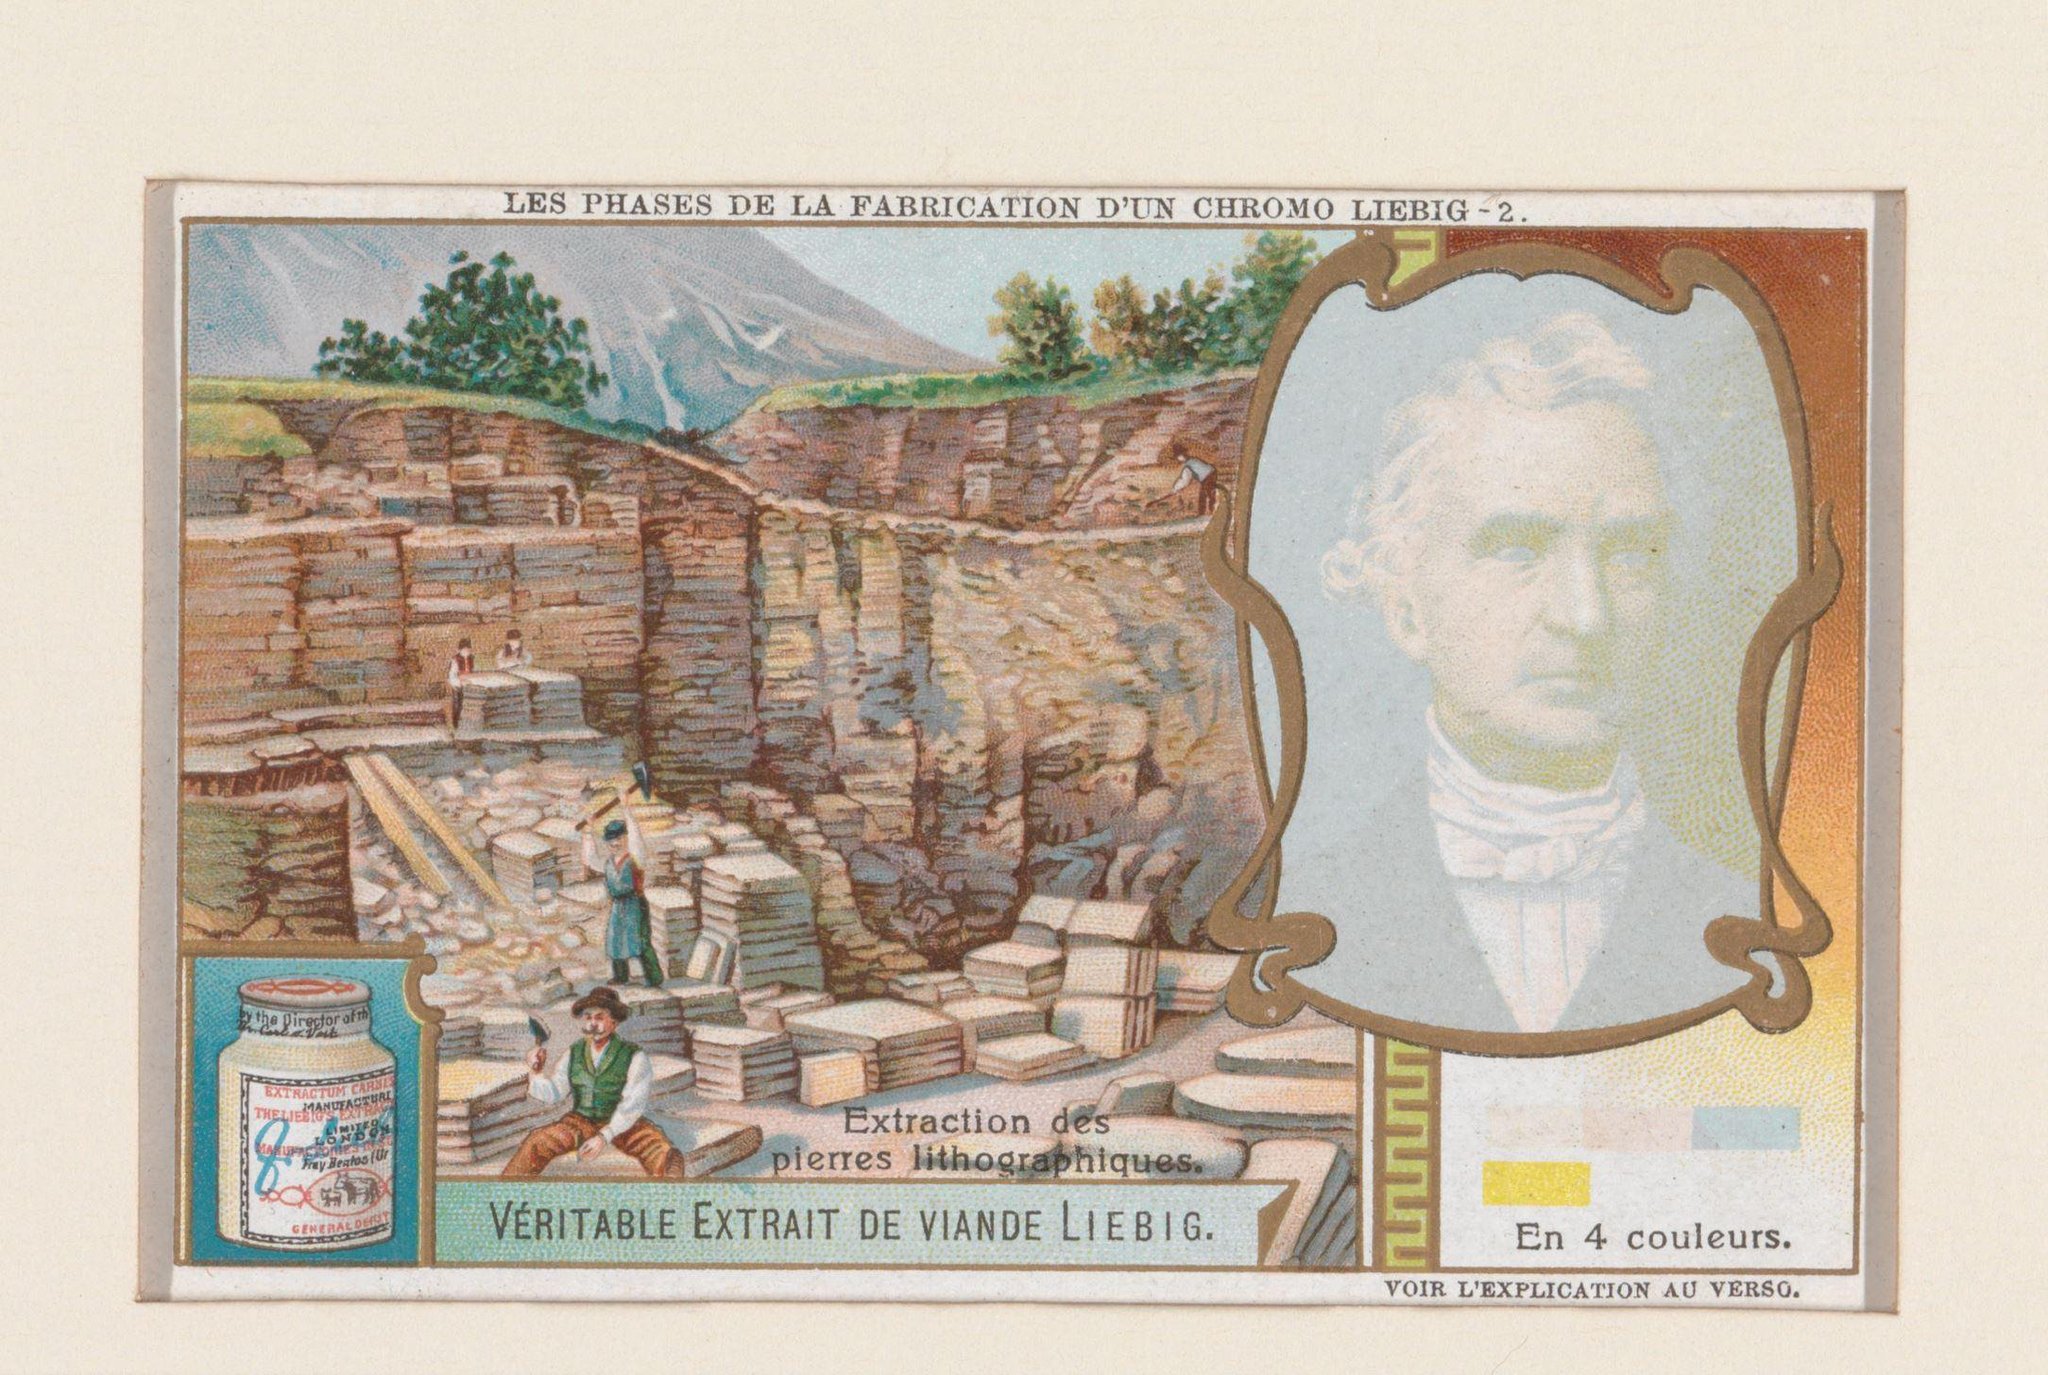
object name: print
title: Les Phases de la Fabrication d'un Chromo Liebig / Véritable extrait de viande Liebig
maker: Anonymous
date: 1906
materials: paper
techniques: chromolithography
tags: historical persons, tools, implements of graphic artist, quarry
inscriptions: title: ‘Extraction des pierres lithographiques’, title: ‘VÉRITABLE EXTRAIT DE VIANDE LIEBIG.’